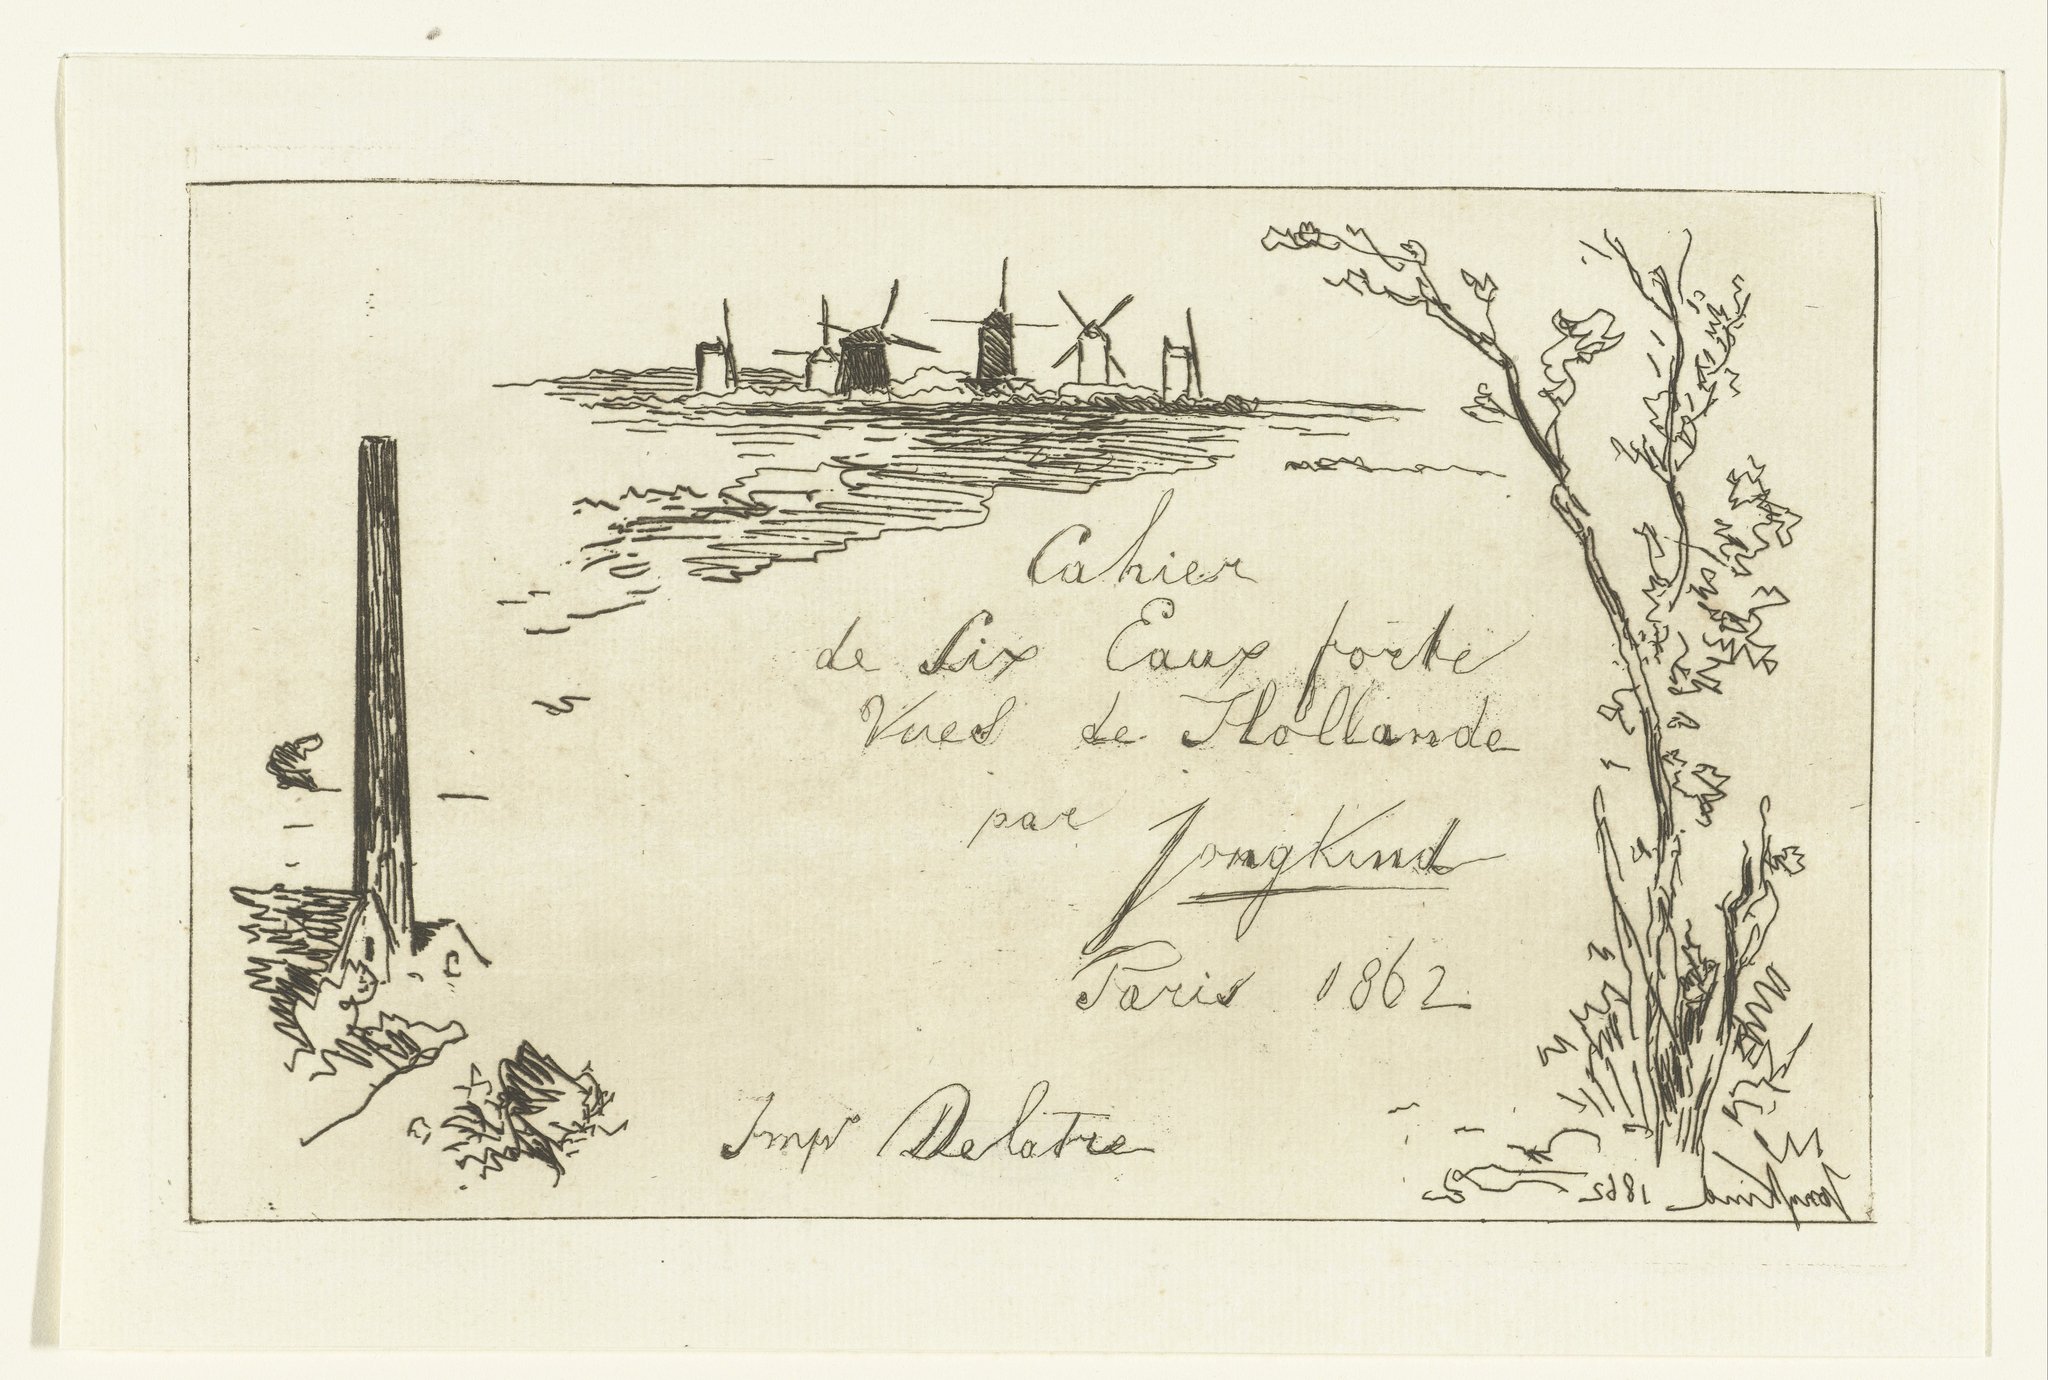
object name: print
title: Titelblad voor een reeks van Hollandse gezichten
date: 1862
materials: paper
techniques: etching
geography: paris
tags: trees, landscapes in the temperate zone, windmill, holland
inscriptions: collector's mark: Lugt 2228a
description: Franse tekst met daaromheen huisjes, molens en een boom. Titelblad voor een serie van zes geëtste Hollandse gezichten, de eerste twee genummerd.